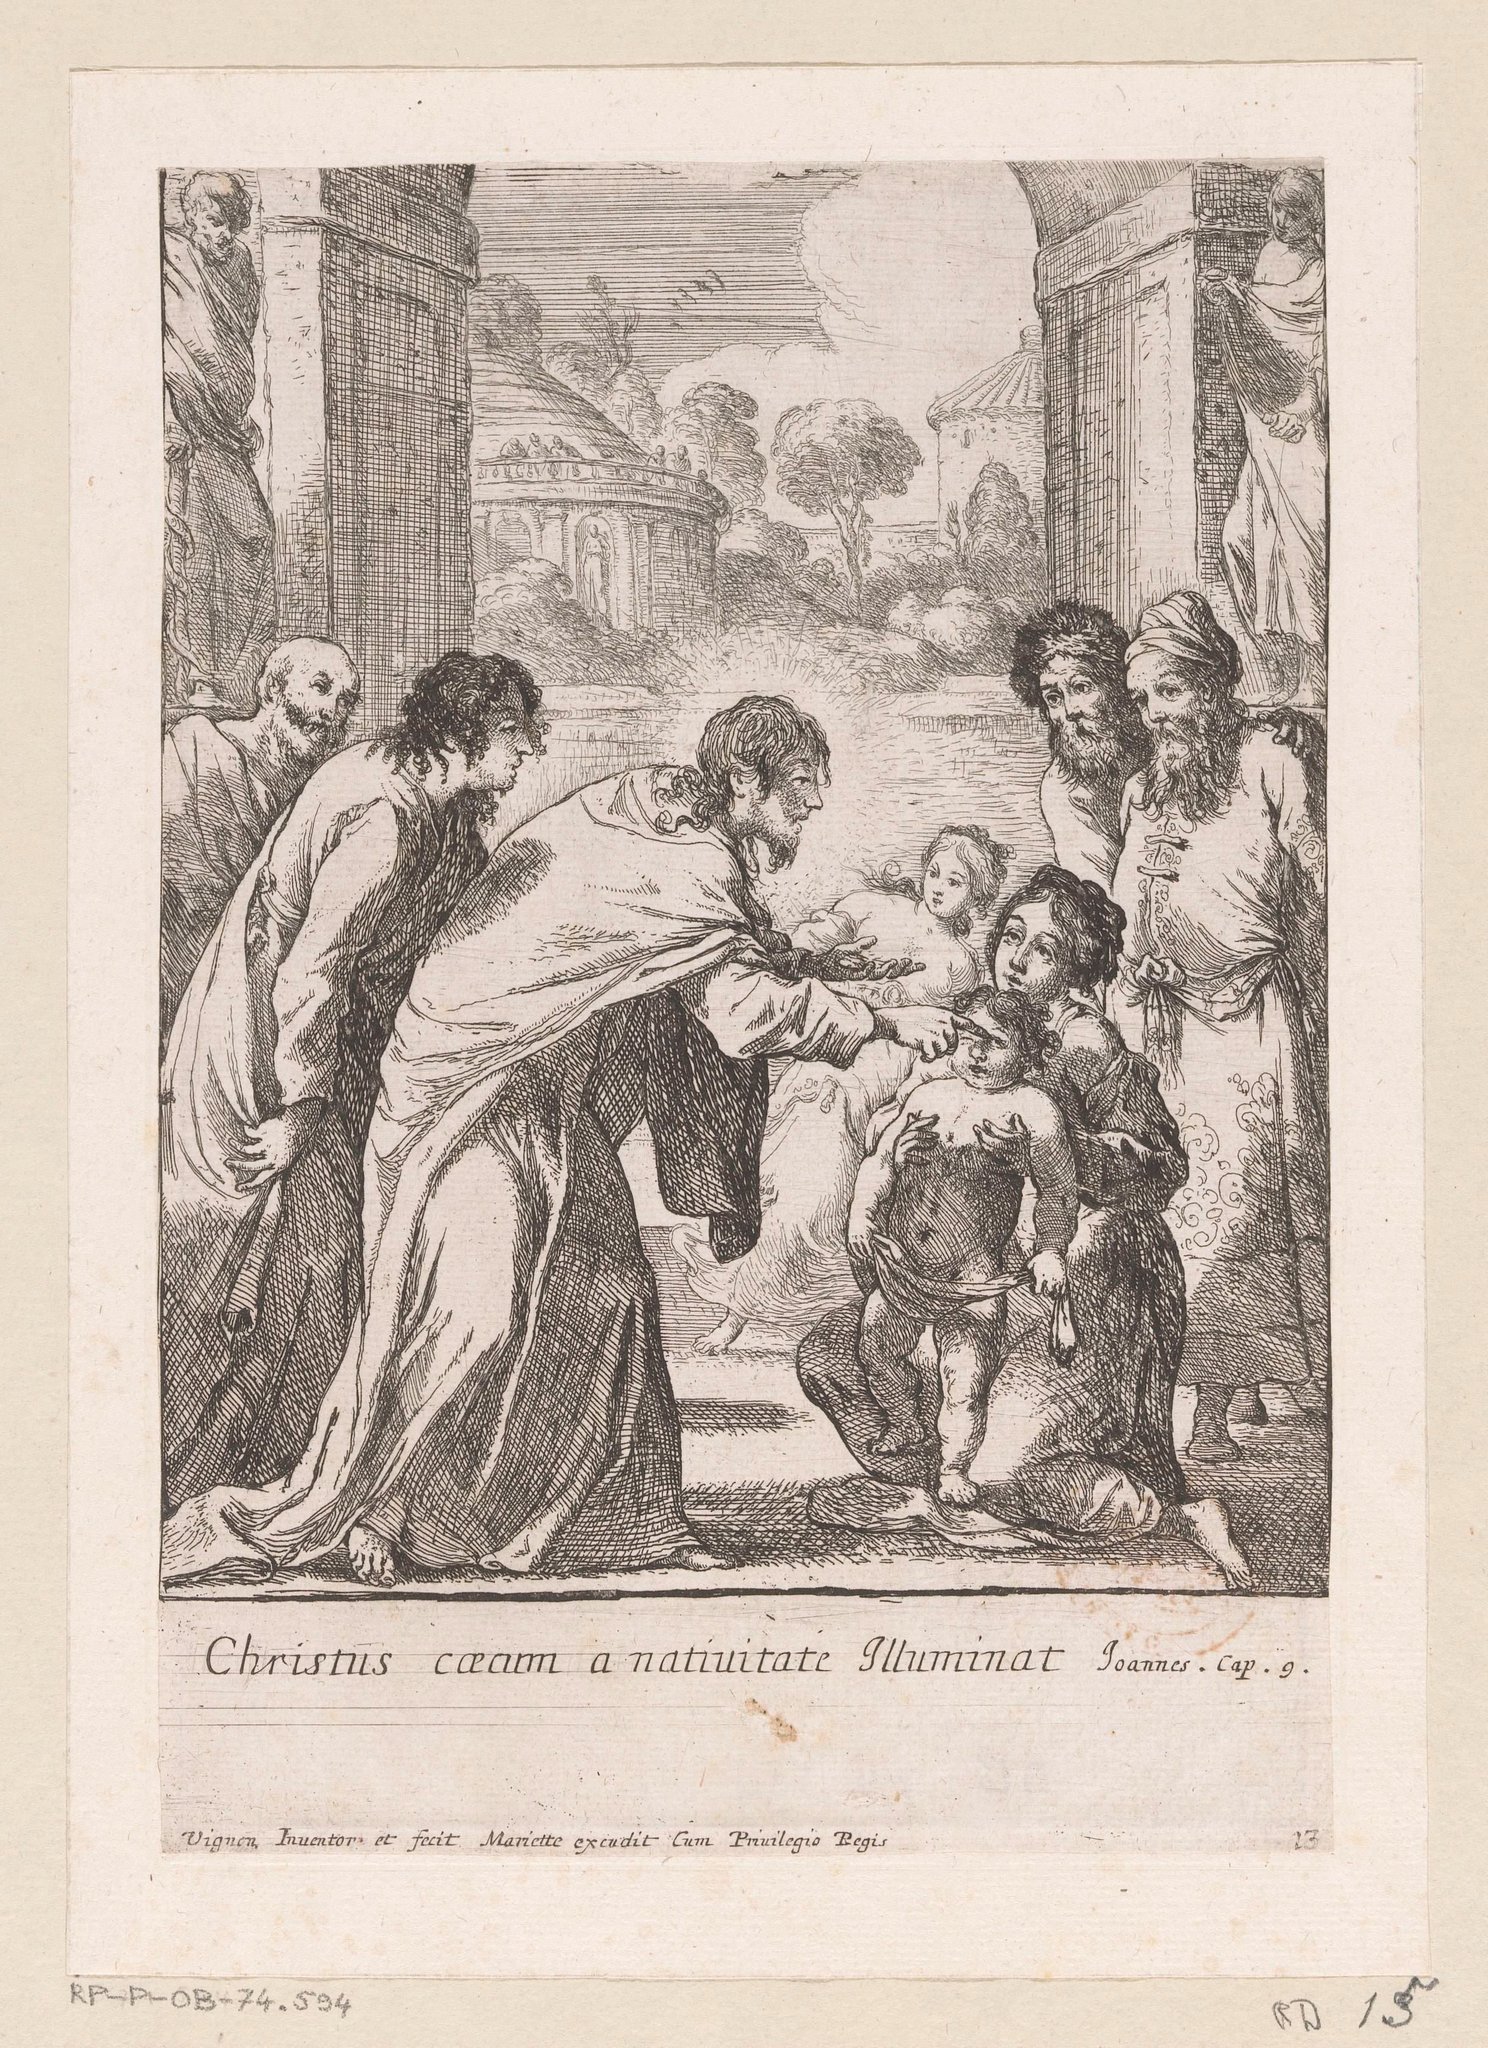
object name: print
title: Genezing van een blindgeborene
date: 1638-1643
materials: paper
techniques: drypoint, etching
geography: paris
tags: christ healing blind people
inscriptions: collector's mark: Lugt 240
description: Maakt deel uit van een serie van dertien prenten voorstellende de wonderen van Christus, opgedragen aan de arts Charles Delorme (1584-1678).